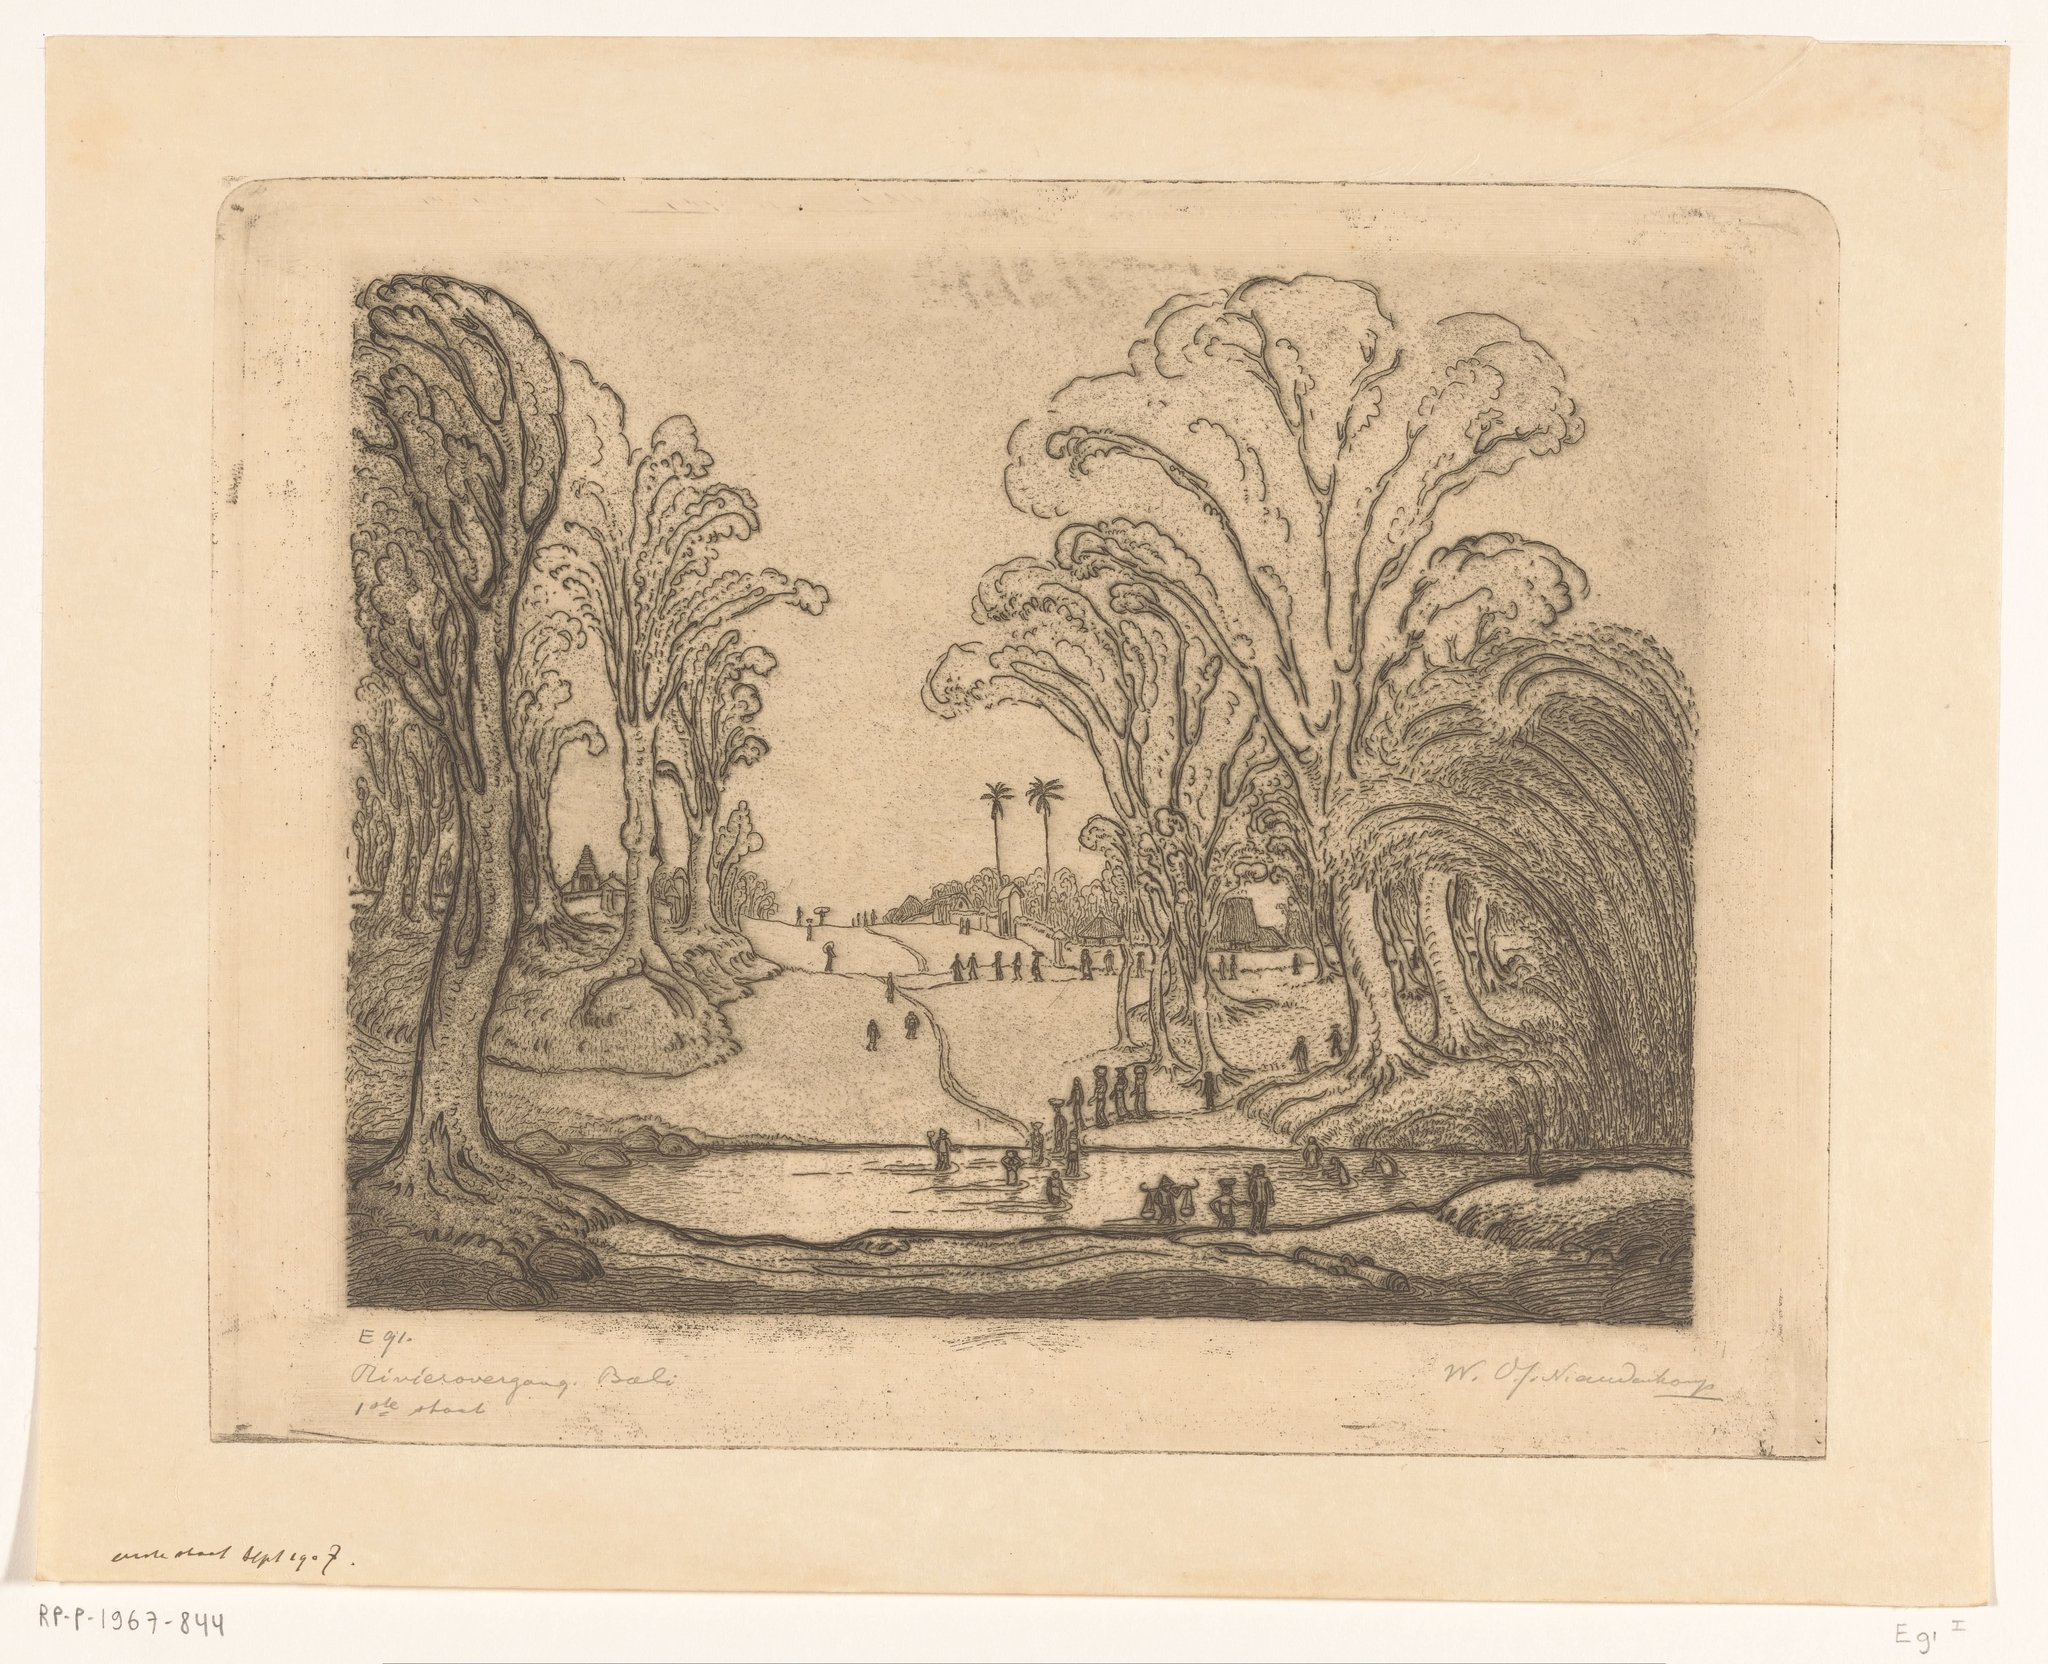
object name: print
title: Rivierovergang, Bali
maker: wijnand otto jan nieuwenkamp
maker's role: draughtsman, print maker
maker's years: 1874-1950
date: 1907-1909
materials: paper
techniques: intaglio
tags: river, wading, paddling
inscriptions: collector's mark: Lugt 2760, collector's mark: Lugt 2228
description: Een doorwaadbaar gedeelte van een rivier in Denpasar op Bali.